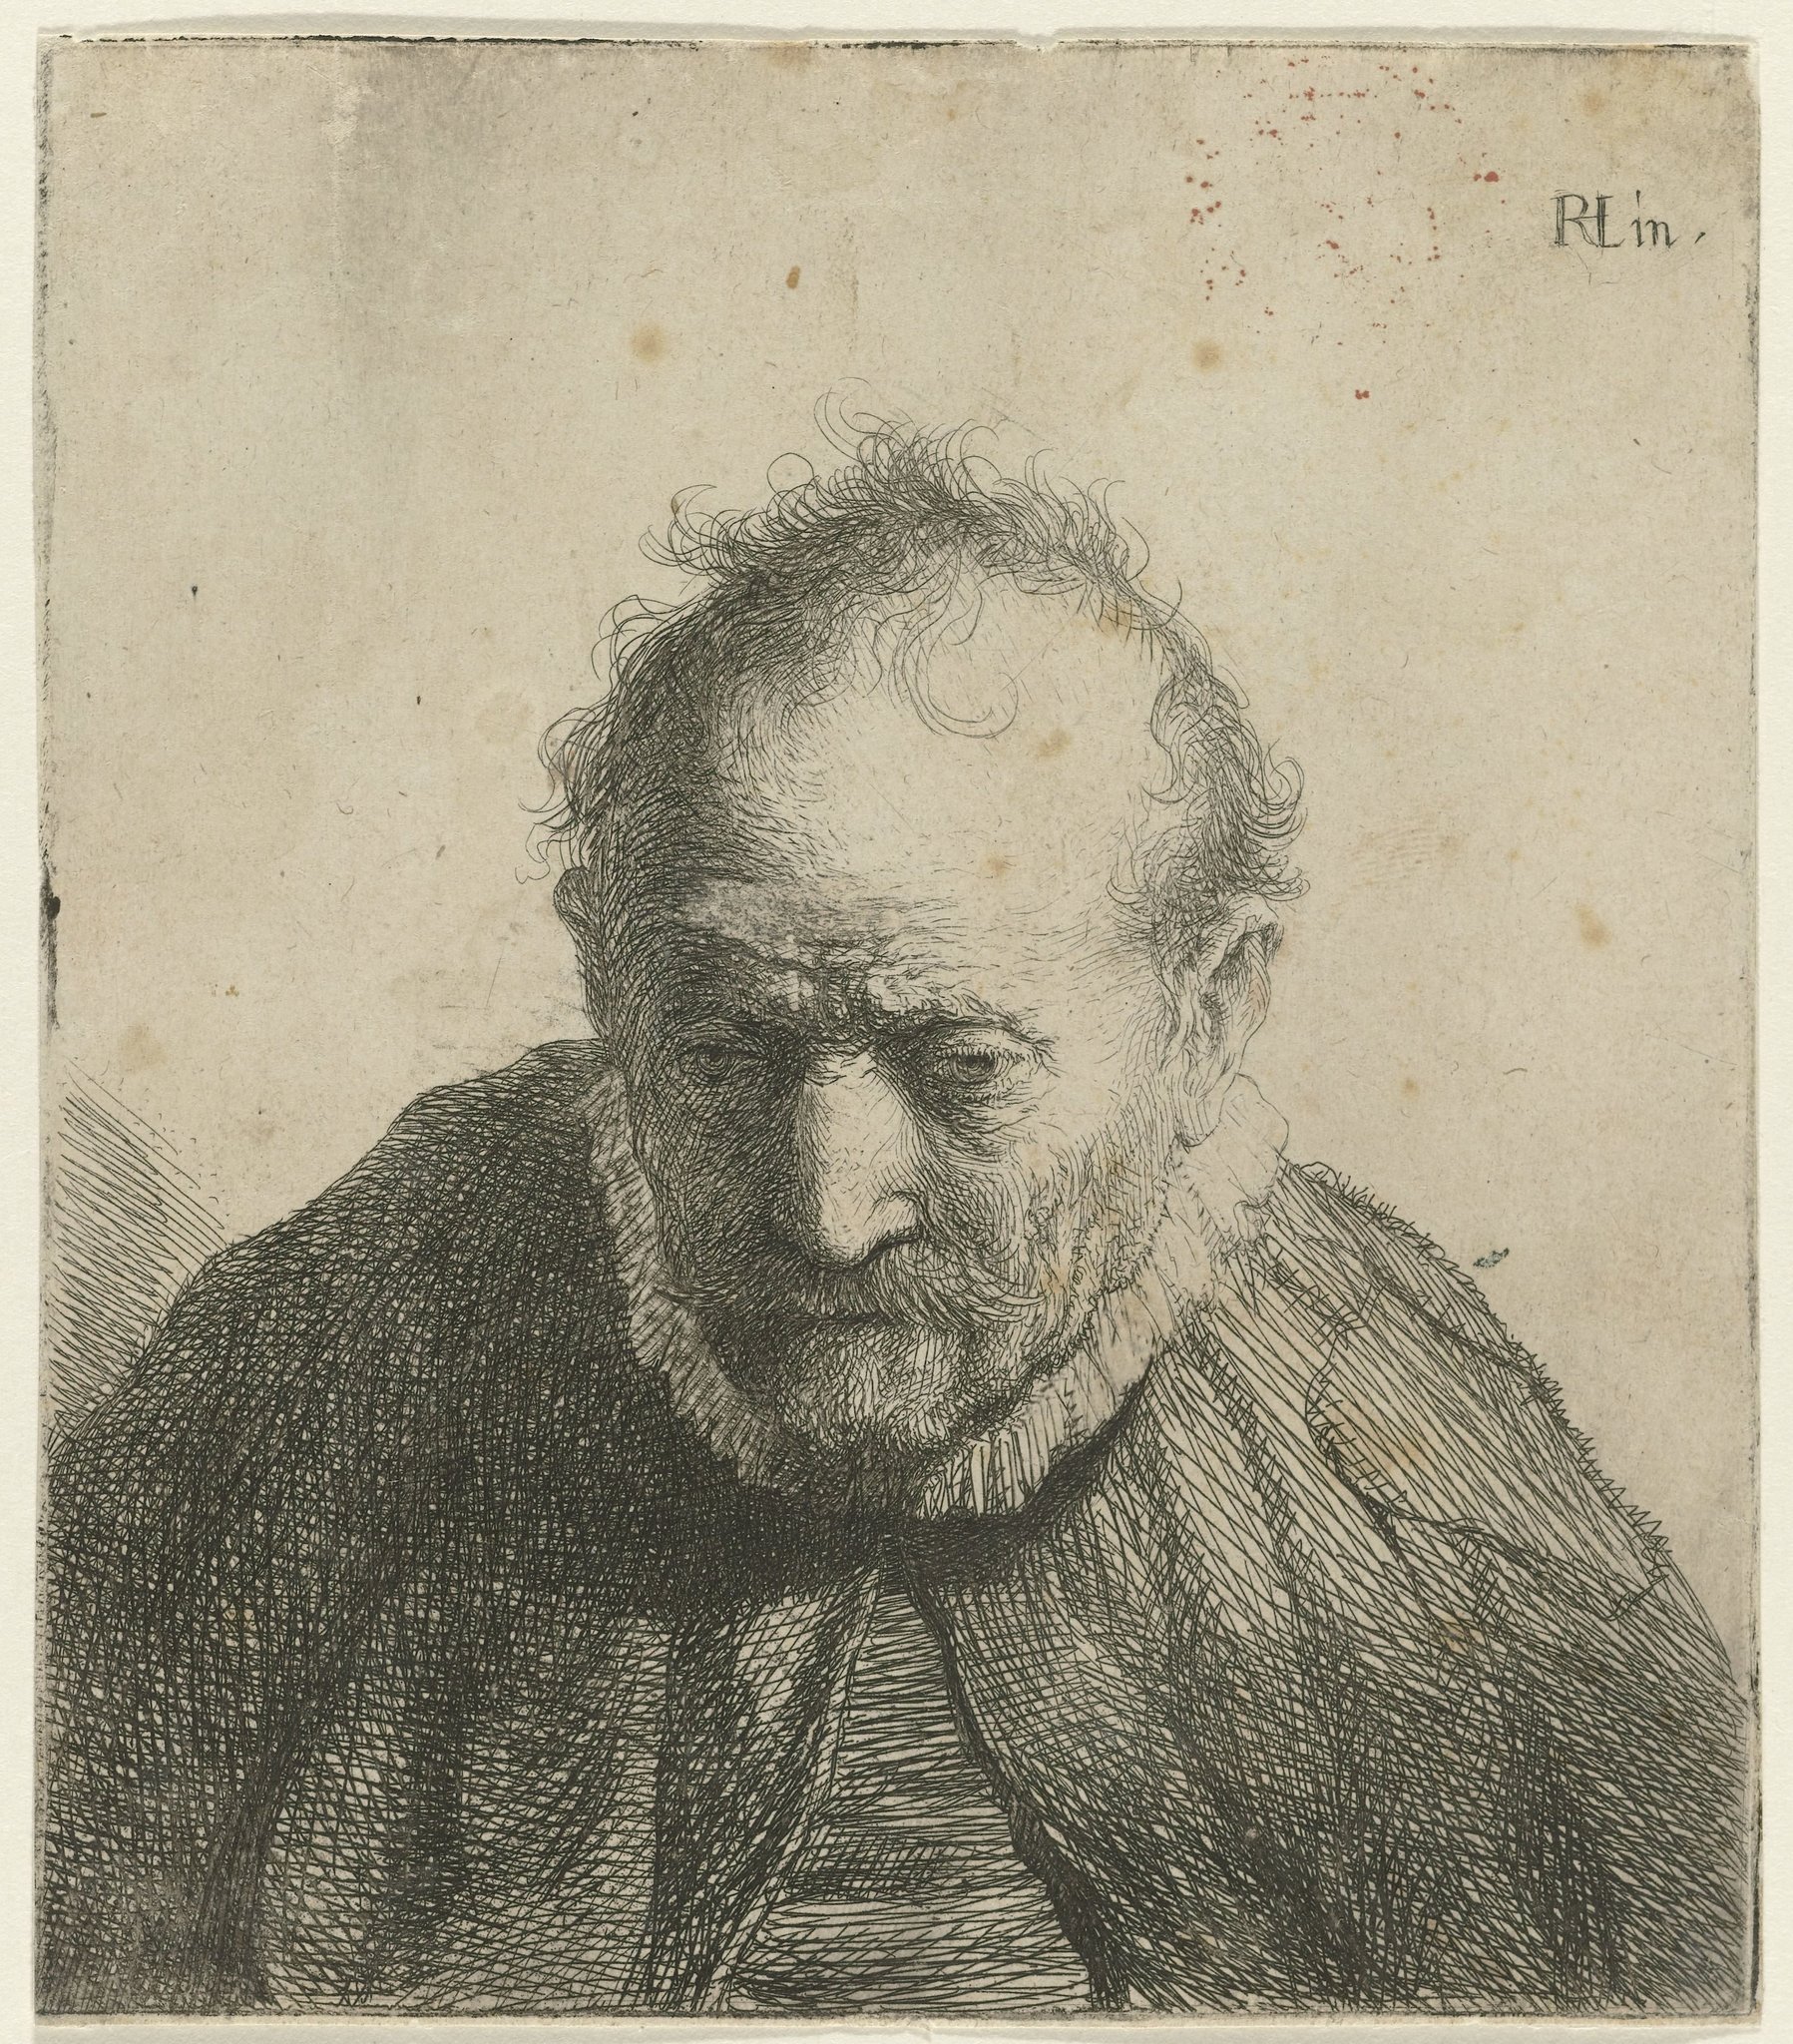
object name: print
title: Buste van een oude man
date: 1631-1633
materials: paper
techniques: etching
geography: leiden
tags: old man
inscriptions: collector's mark: Lugt 240, collector's mark: Lugt 2228